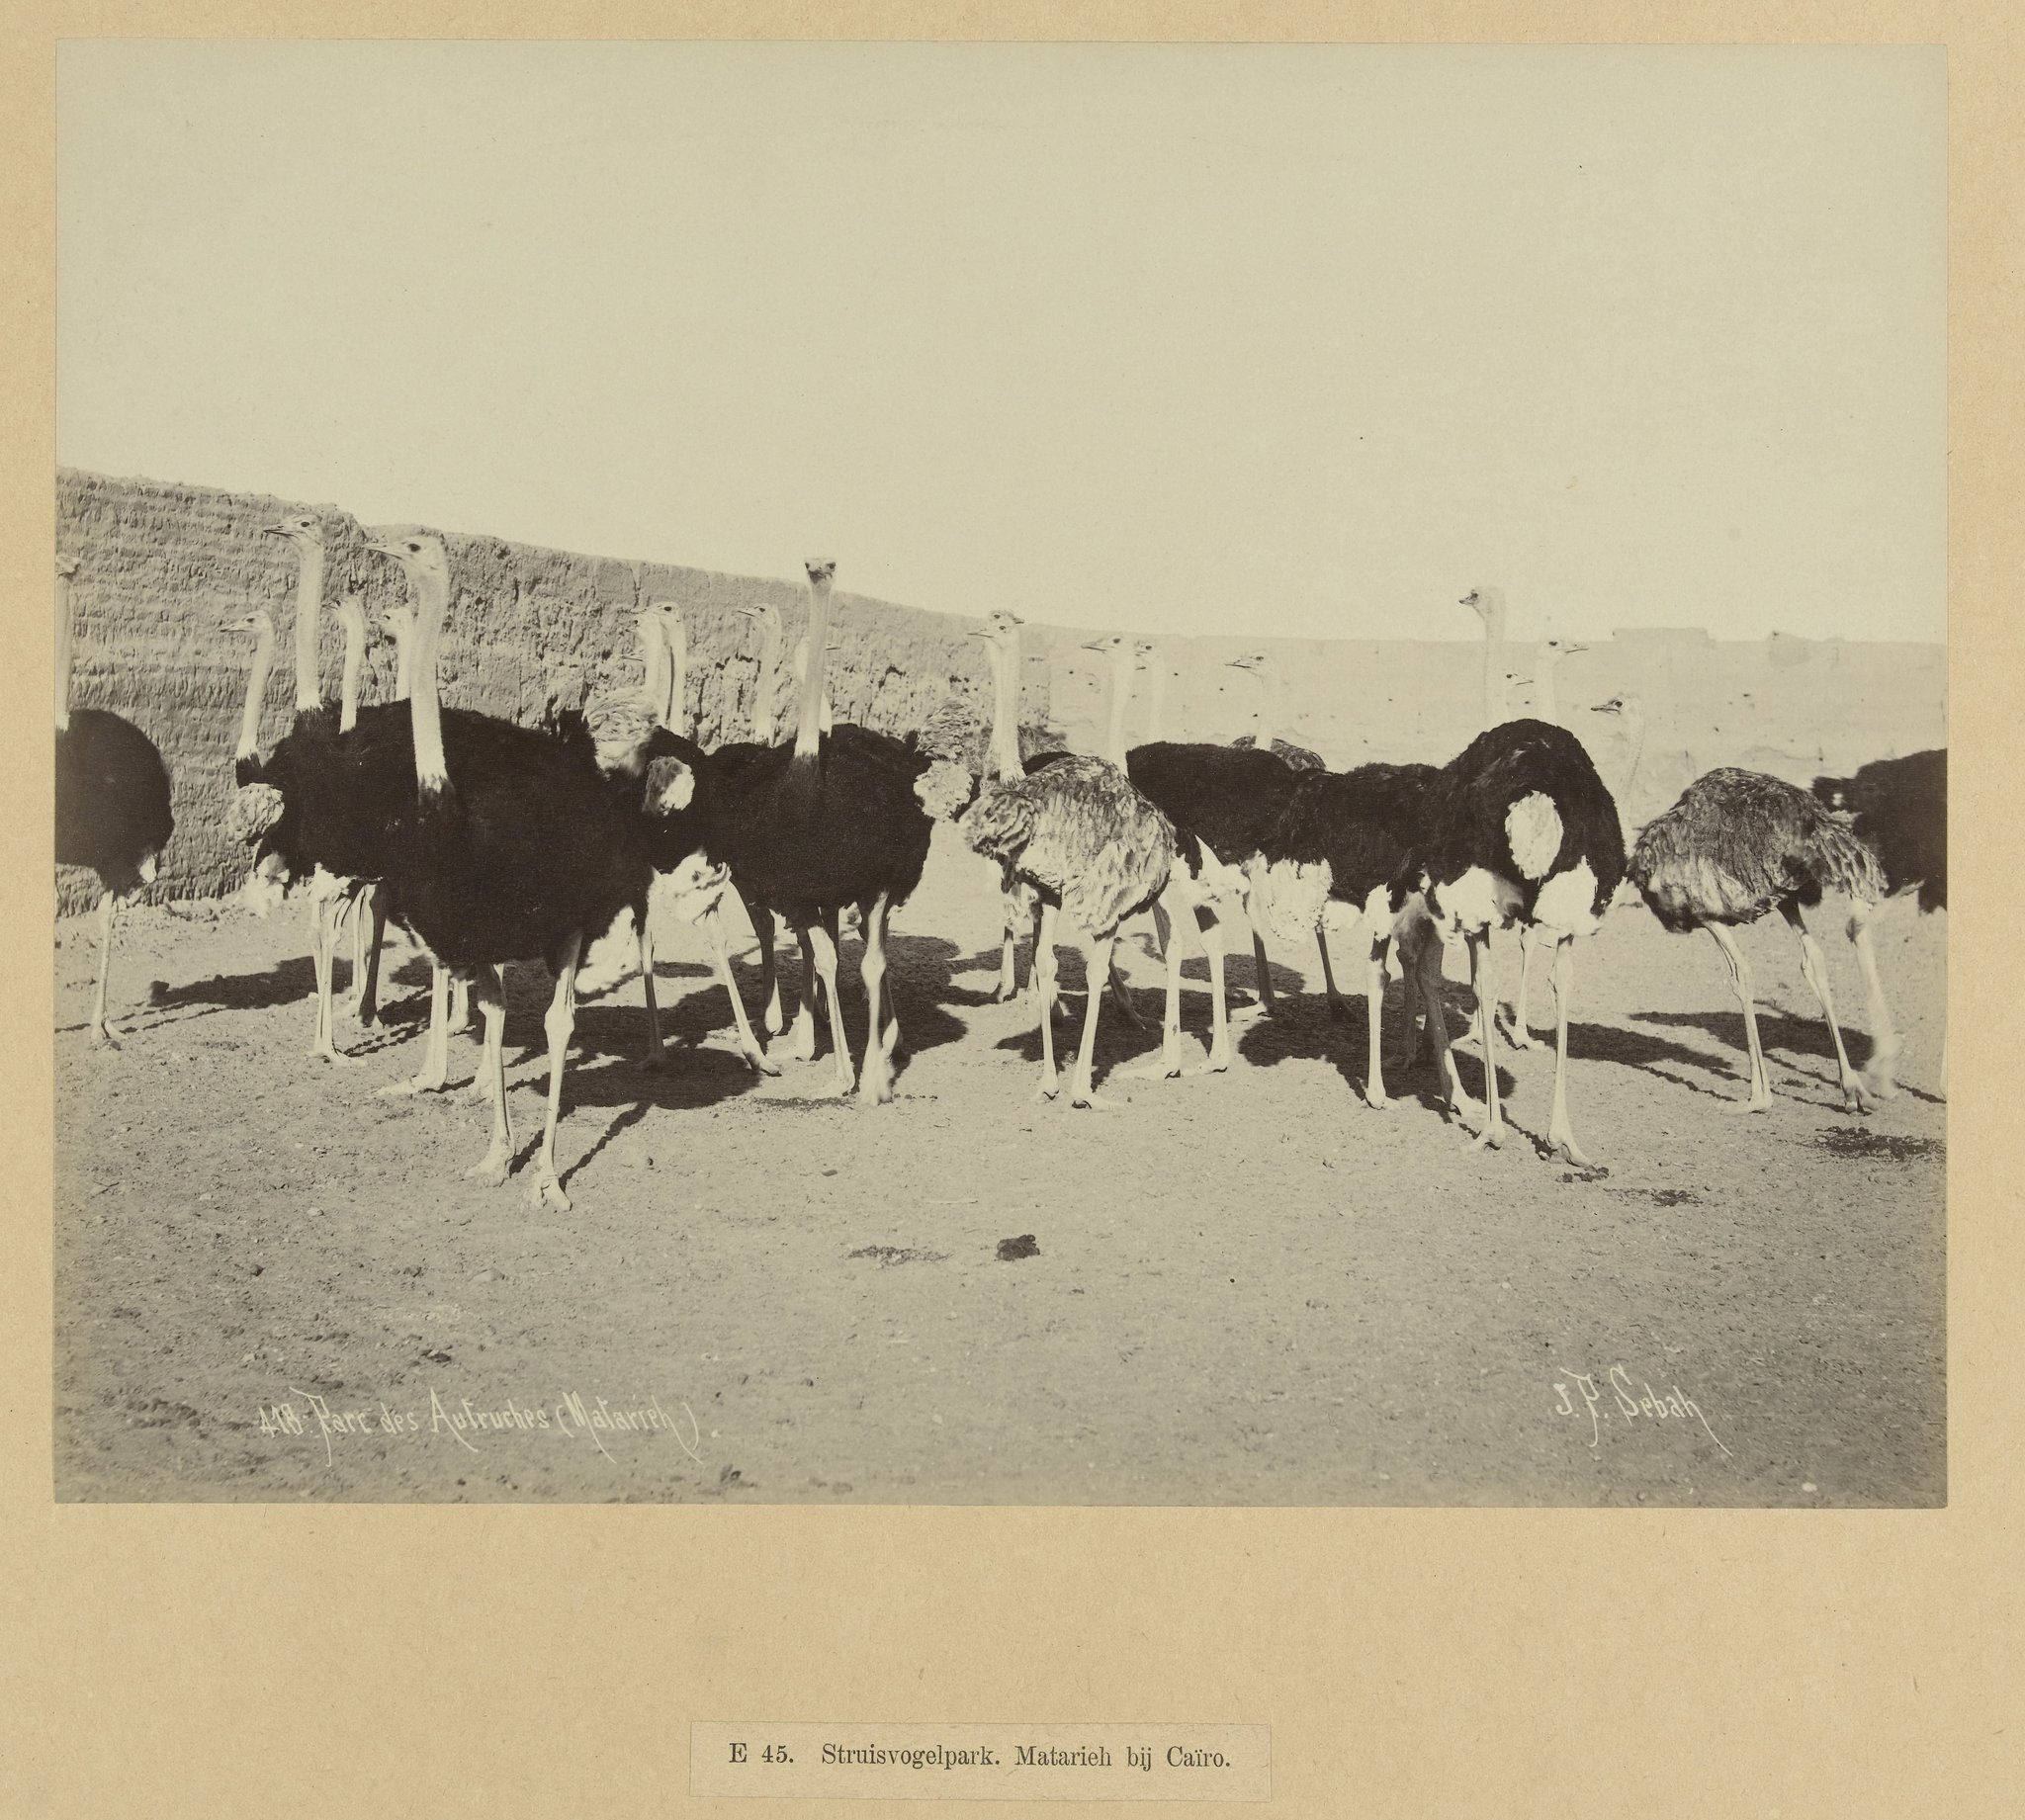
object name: photograph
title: E 45. Struisvogelpark. Matarieh bij Caïro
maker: jean pascal sébah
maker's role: fotograaf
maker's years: 1872-1947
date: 1888-1895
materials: cardboard, paper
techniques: albumen print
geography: el matareya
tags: walker and runner birds: ostrich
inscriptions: check stamp: ‘Bristol/ L.M.’, stamp: ‘Gemeentelijke bibliotheek/ Rotterdam’, number: ‘418’, title: ‘E 45. Struisvogelpark. Maratieh bij Caïro.’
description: Onderdeel van een groep door fotograaf Richard Polak op reis verzamelde foto’s. Deze foto is samen met andere op zijn reizen verzamelde foto's tentoongesteld bij de Rotterdamsche Kunstkring (1895), Arti en Amicitiae te Amsterdam (1897-1898?) en Societeit 't Collegie te Kampen (datum vooralsnog onbekend).